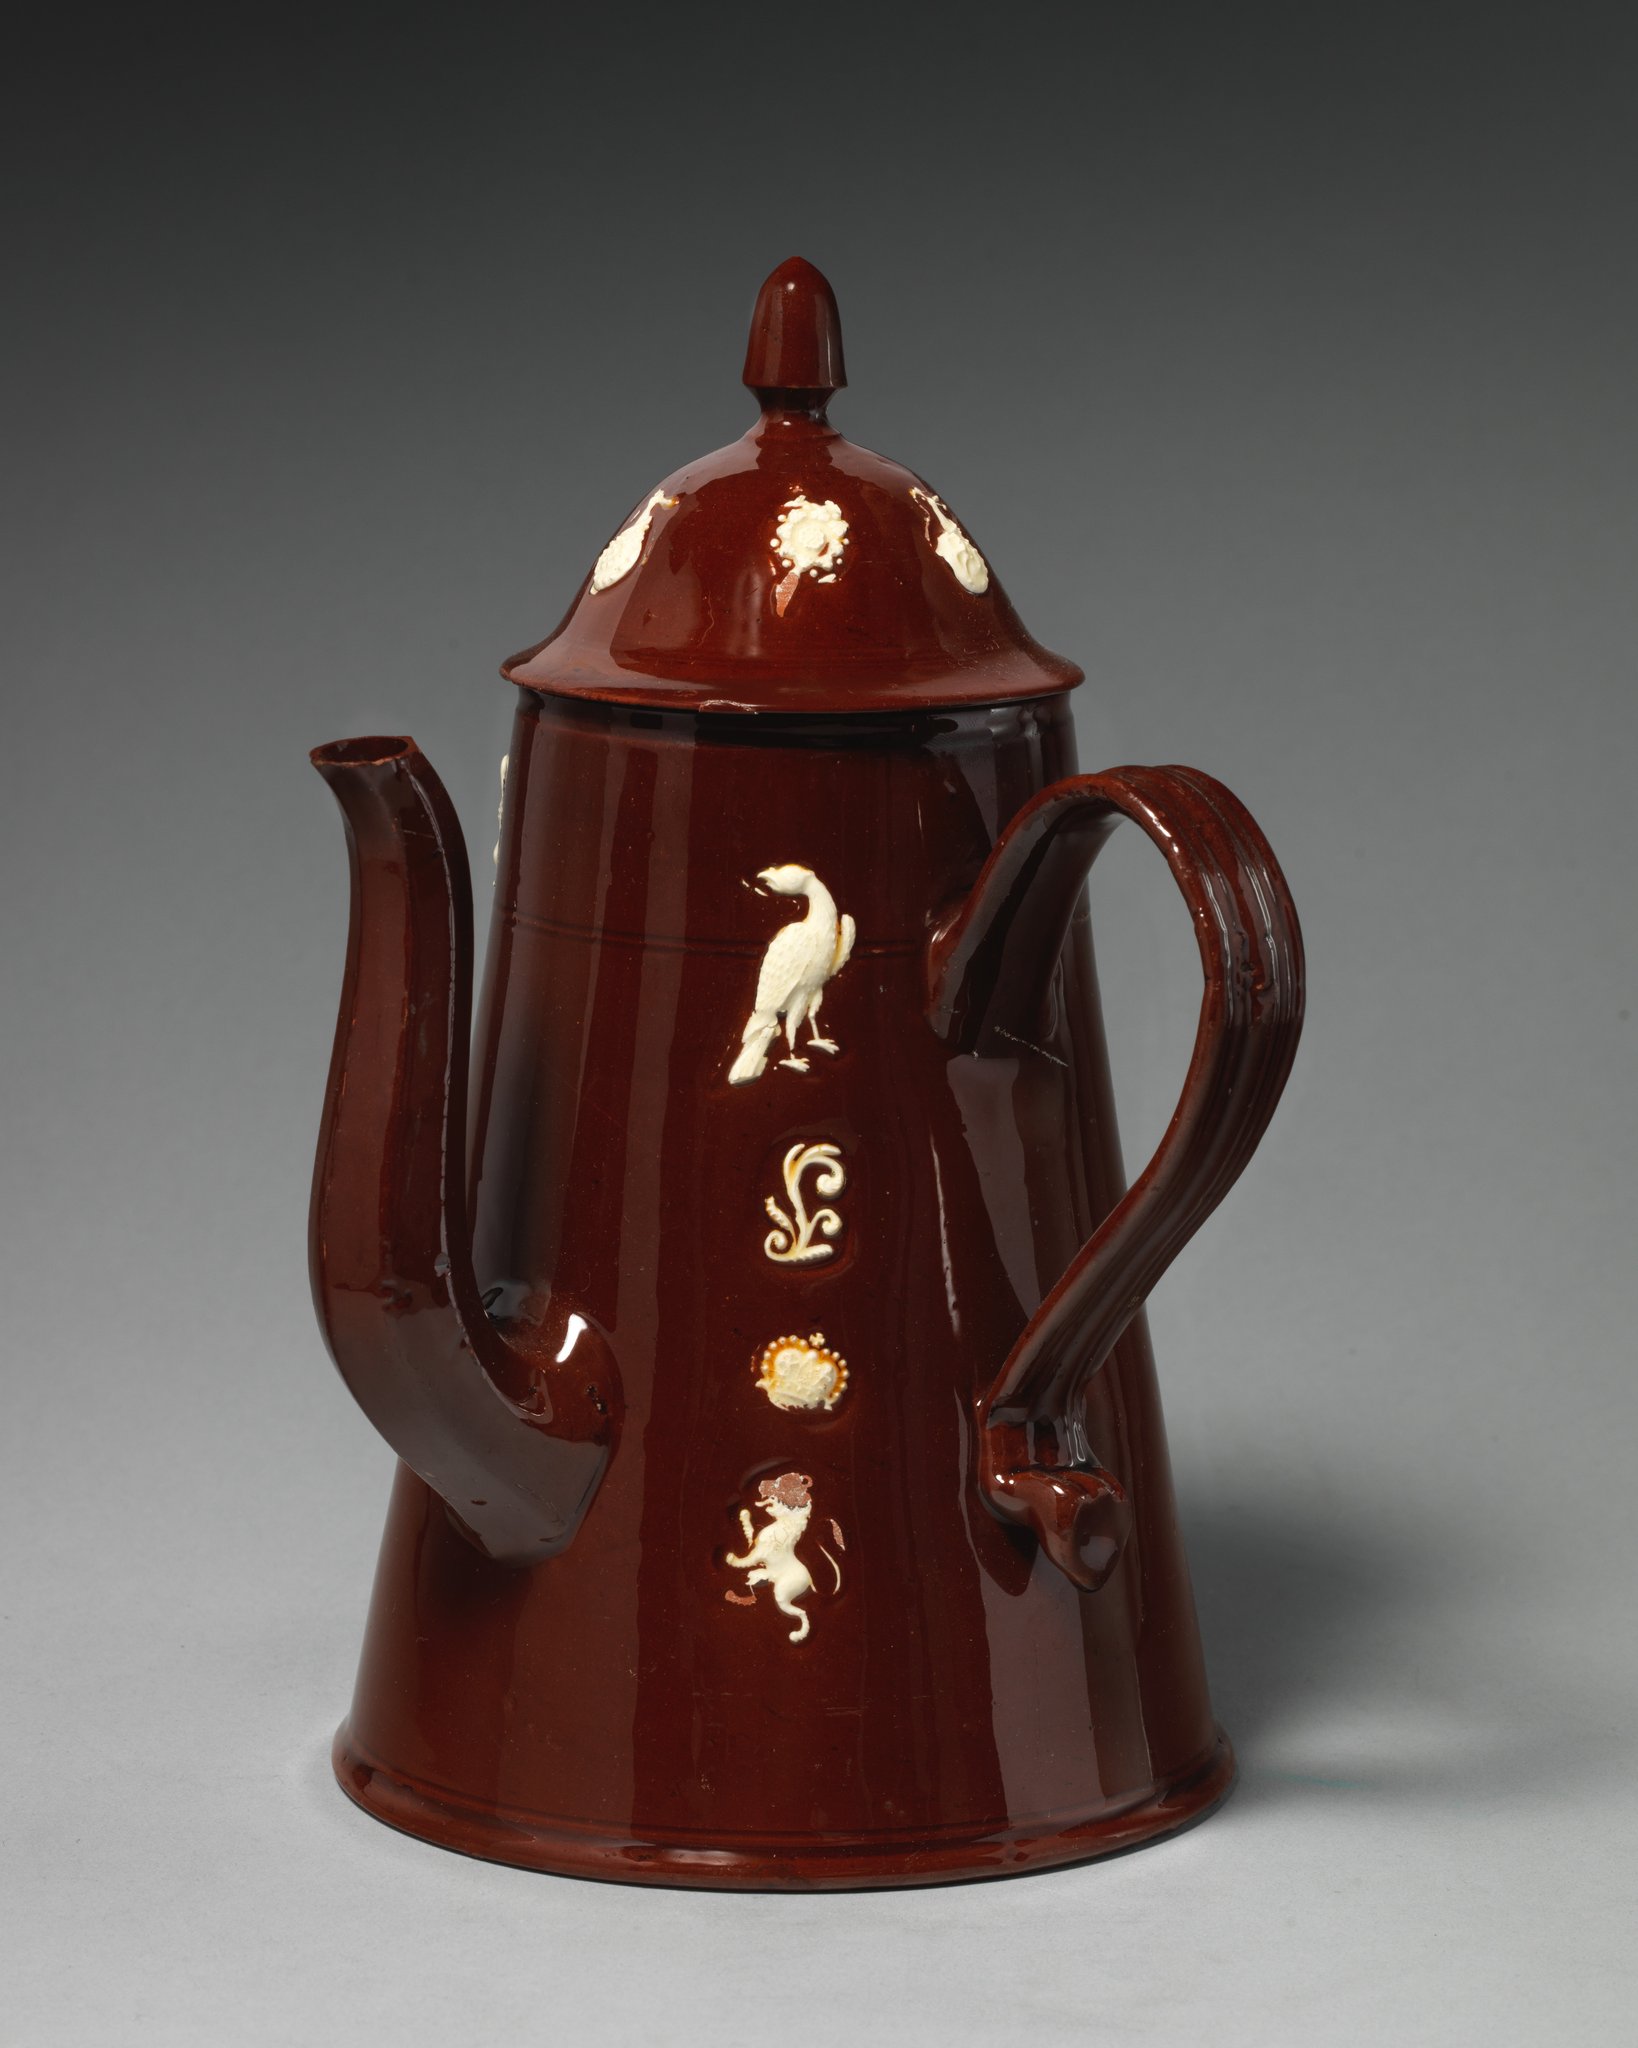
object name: coffeepot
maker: john astbury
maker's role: maker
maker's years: 1688-1743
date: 1740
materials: earthenware, glaze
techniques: glazing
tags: eagles,deer,lions,flowers